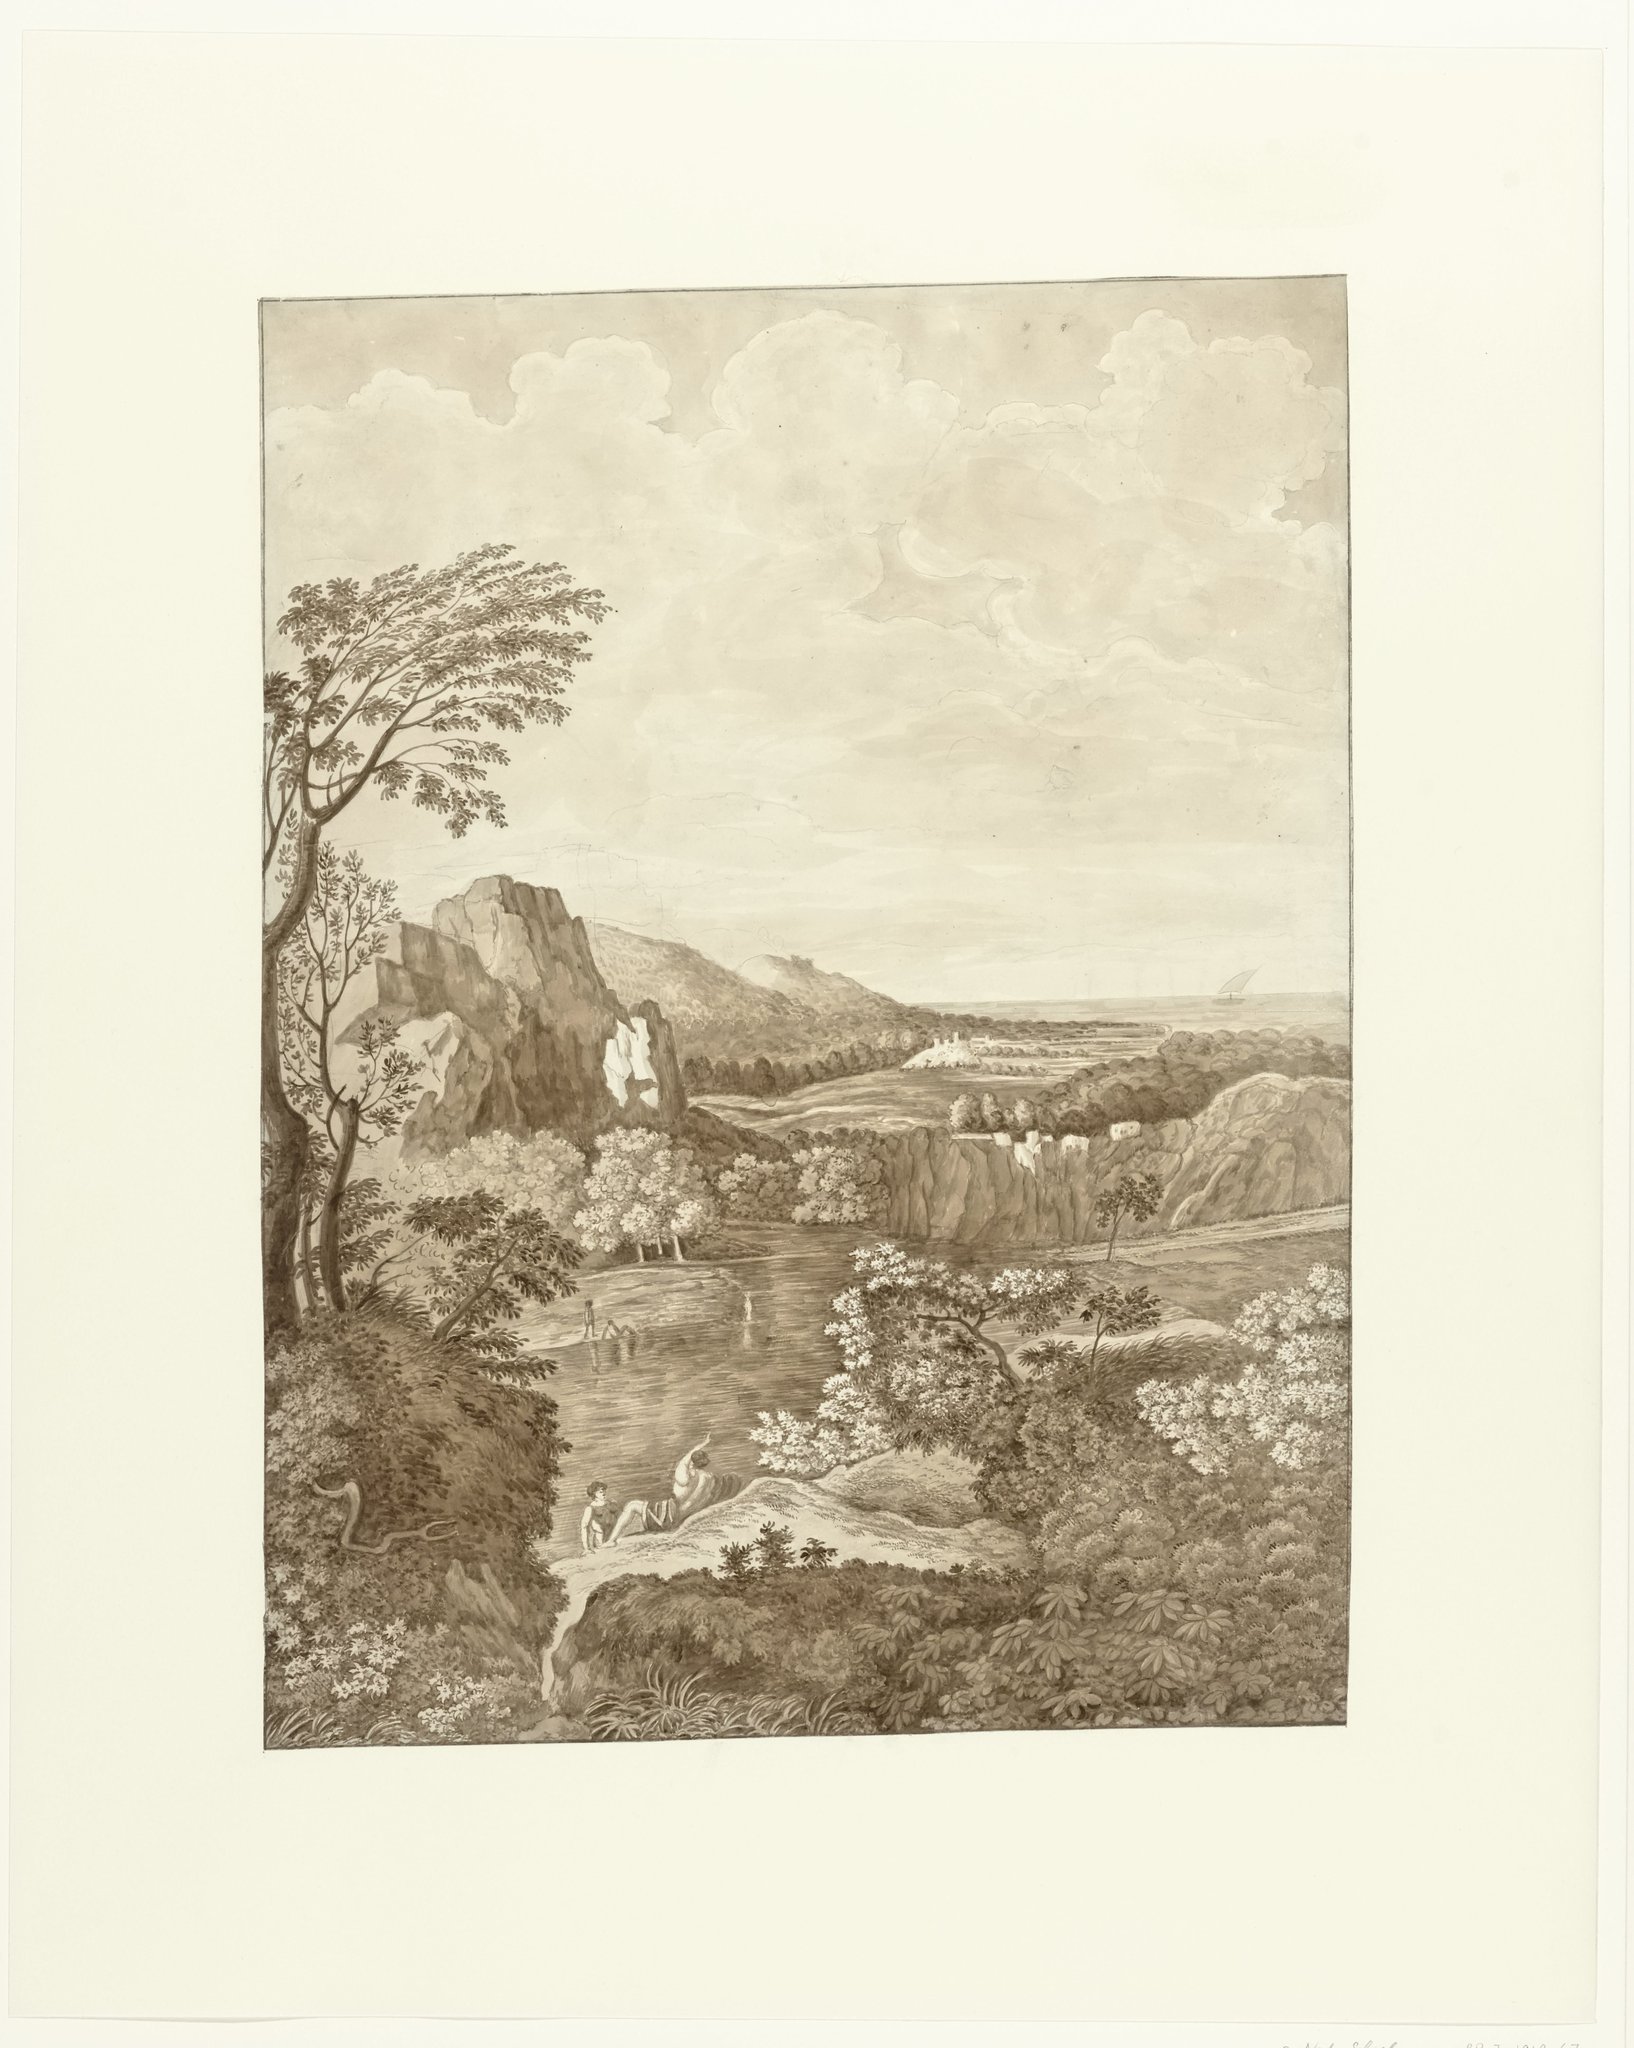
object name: drawing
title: Italiaans landschap in de omgeving van Rome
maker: j. pallard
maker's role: draughtsman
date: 1650-1800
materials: paper, pencil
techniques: brush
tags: landscapes in the temperate zone, italy, rome